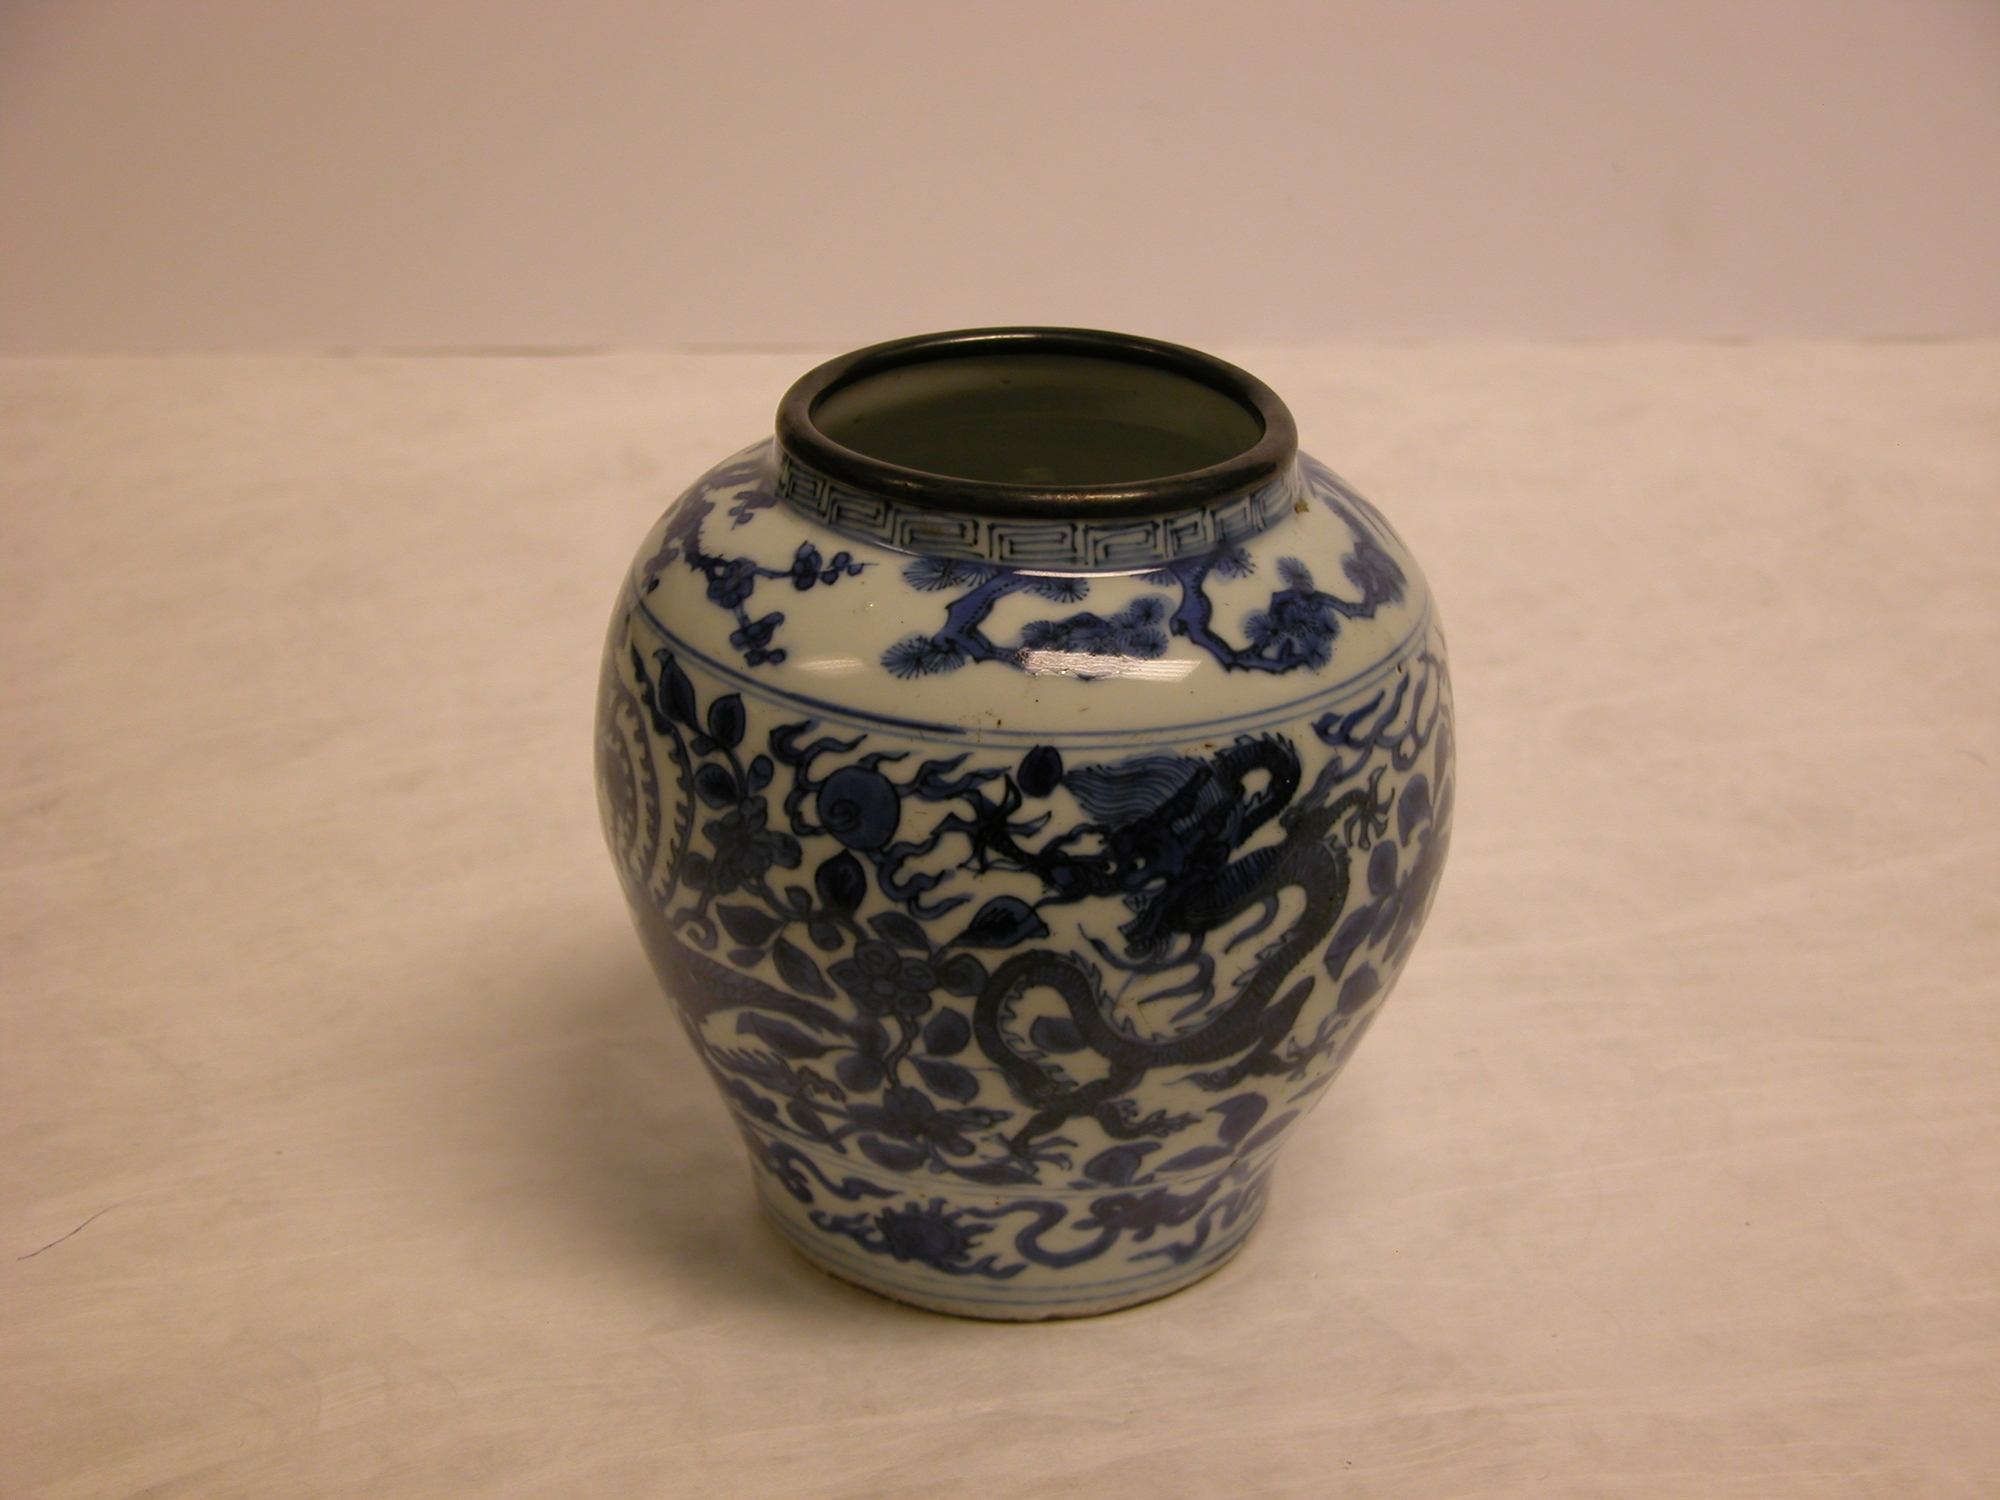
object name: jar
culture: chinese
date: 1573-1620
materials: porcelain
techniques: painting, underglaze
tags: dragons,plants